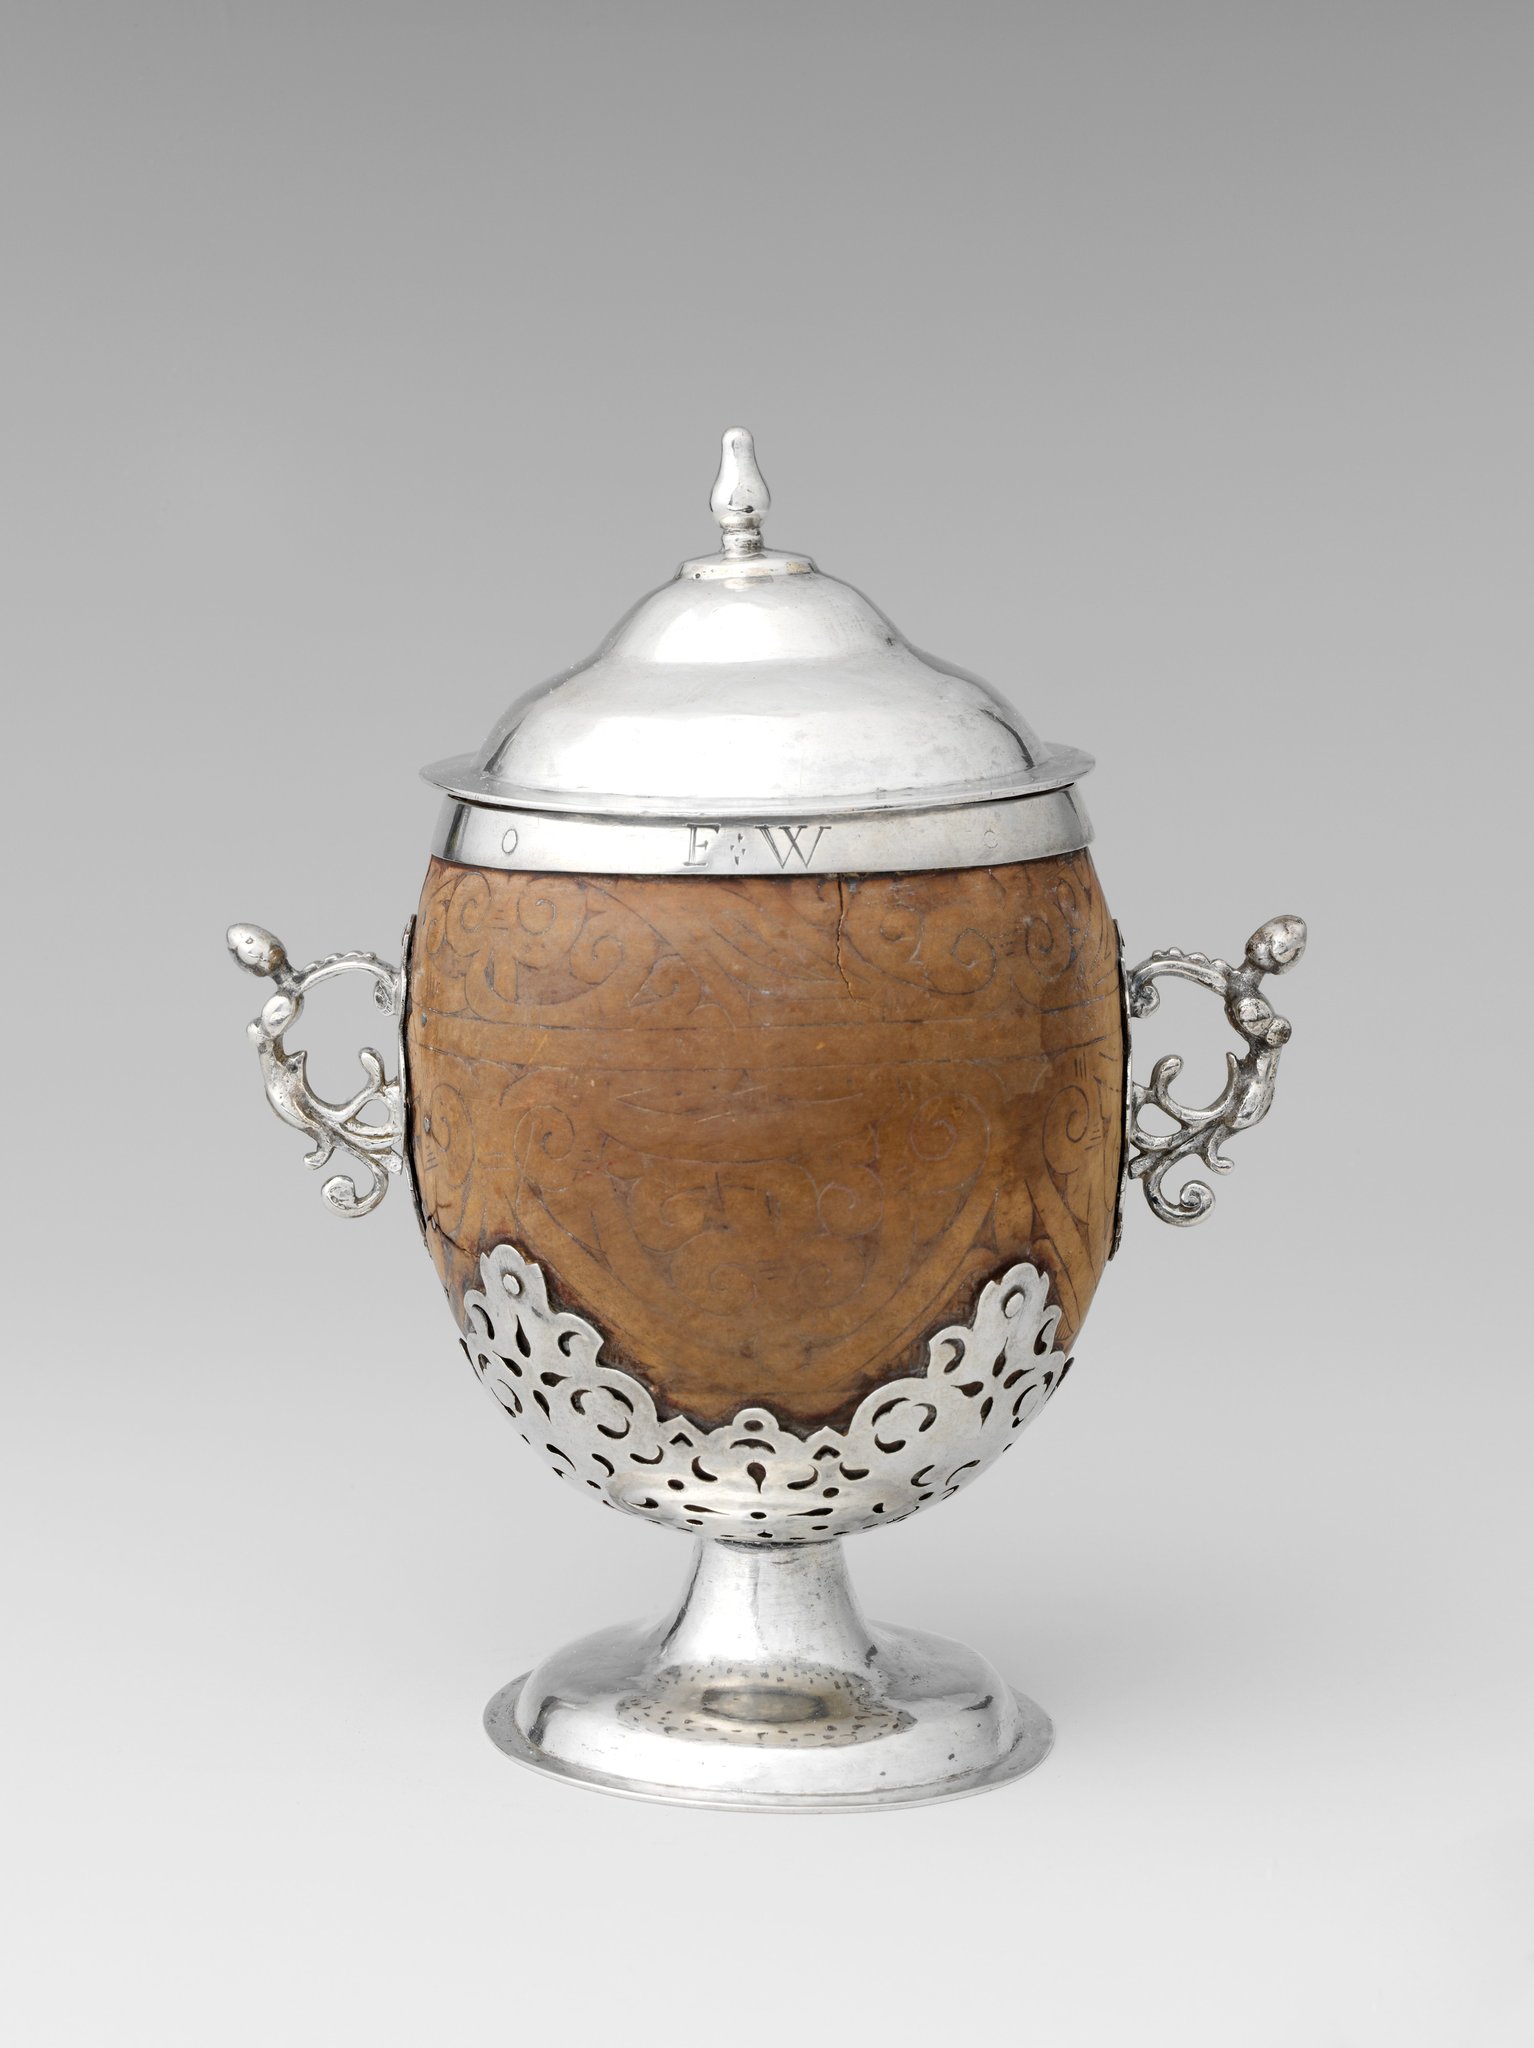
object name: cup with cover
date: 1601-1700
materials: silver